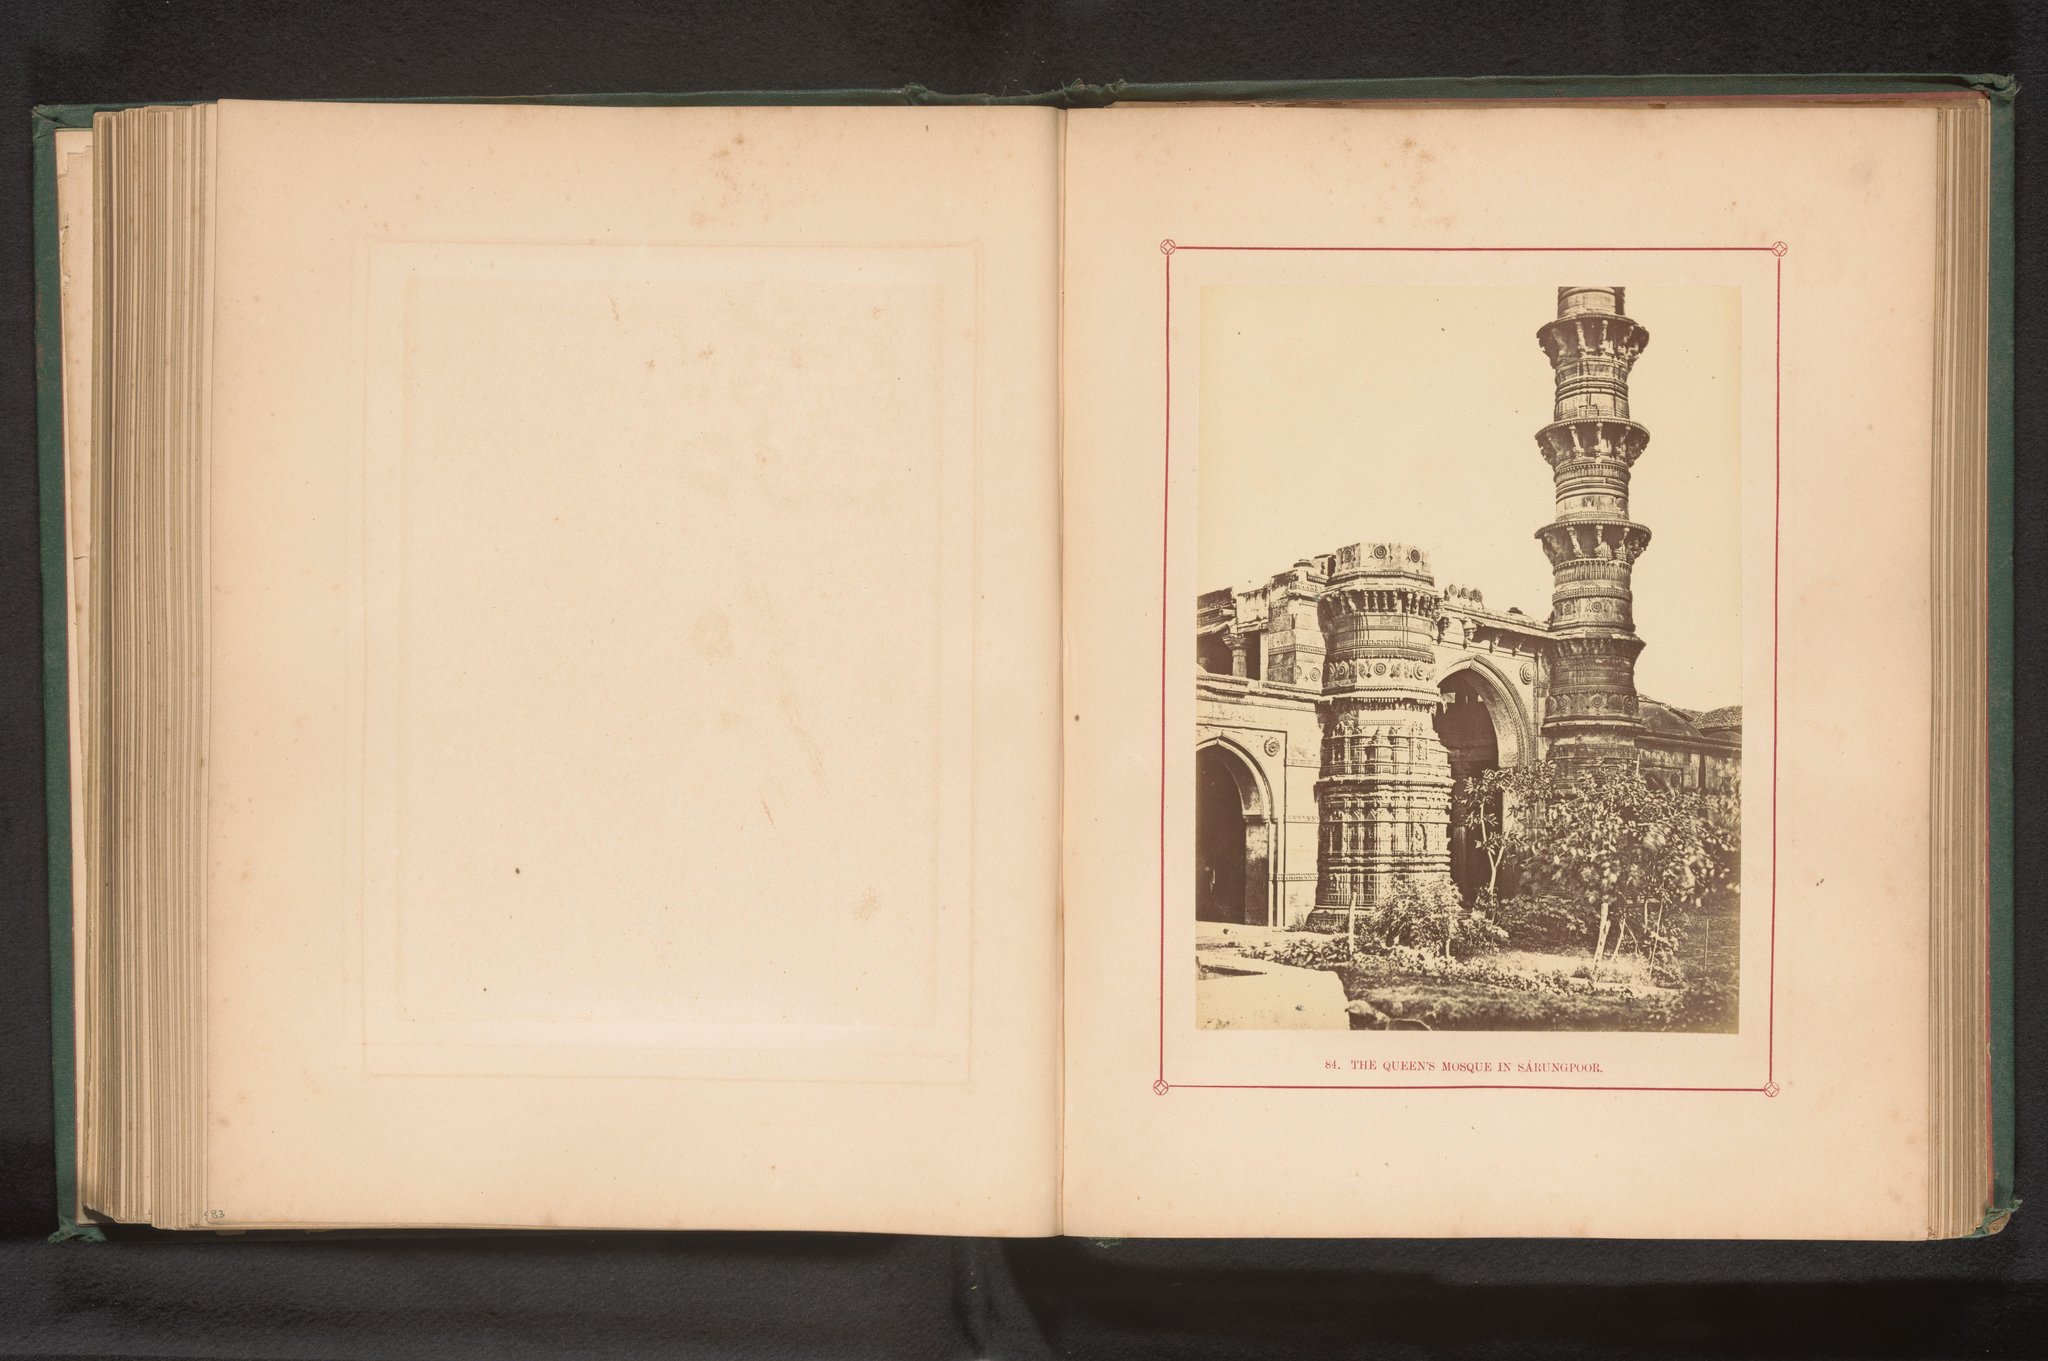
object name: photograph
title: Gezicht op een moskee in Ahmedabad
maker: thomas biggs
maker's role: fotograaf, kapitein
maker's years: 1822-1905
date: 1856-1866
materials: photographic support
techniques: albumen print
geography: ahmedabad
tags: temple, shrine ~ islam, mohammedanism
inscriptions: number: ‘84.’